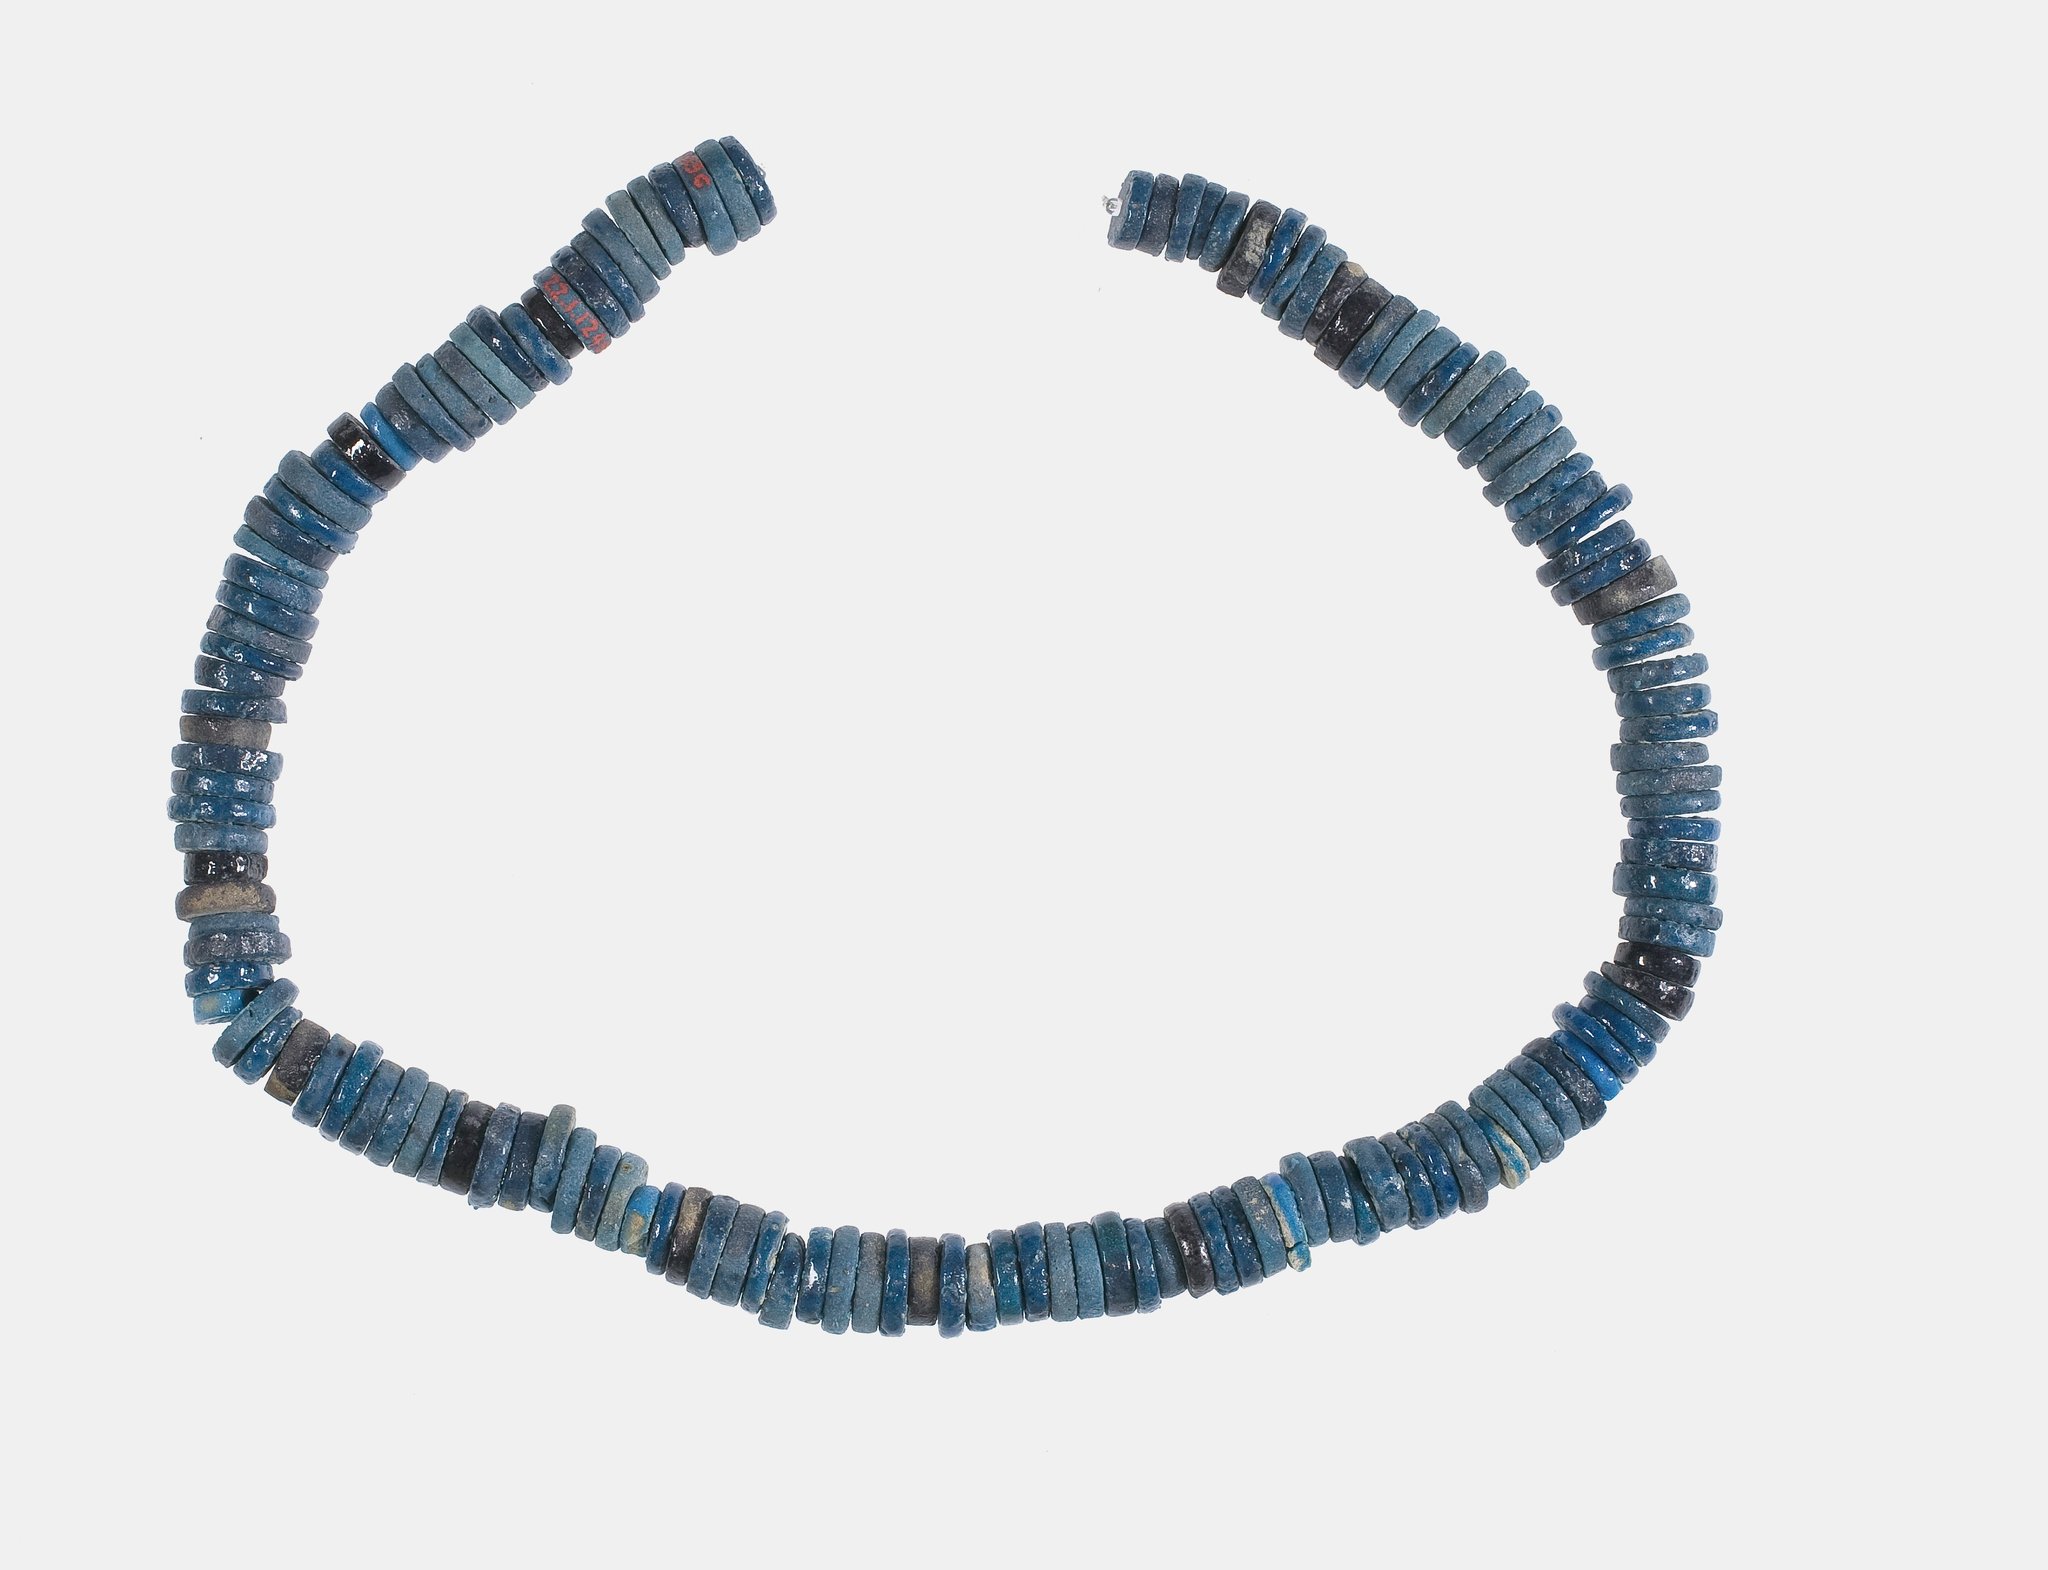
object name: necklace, bead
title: Ring beads on original string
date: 1802-1450 BCE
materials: faience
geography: egypt